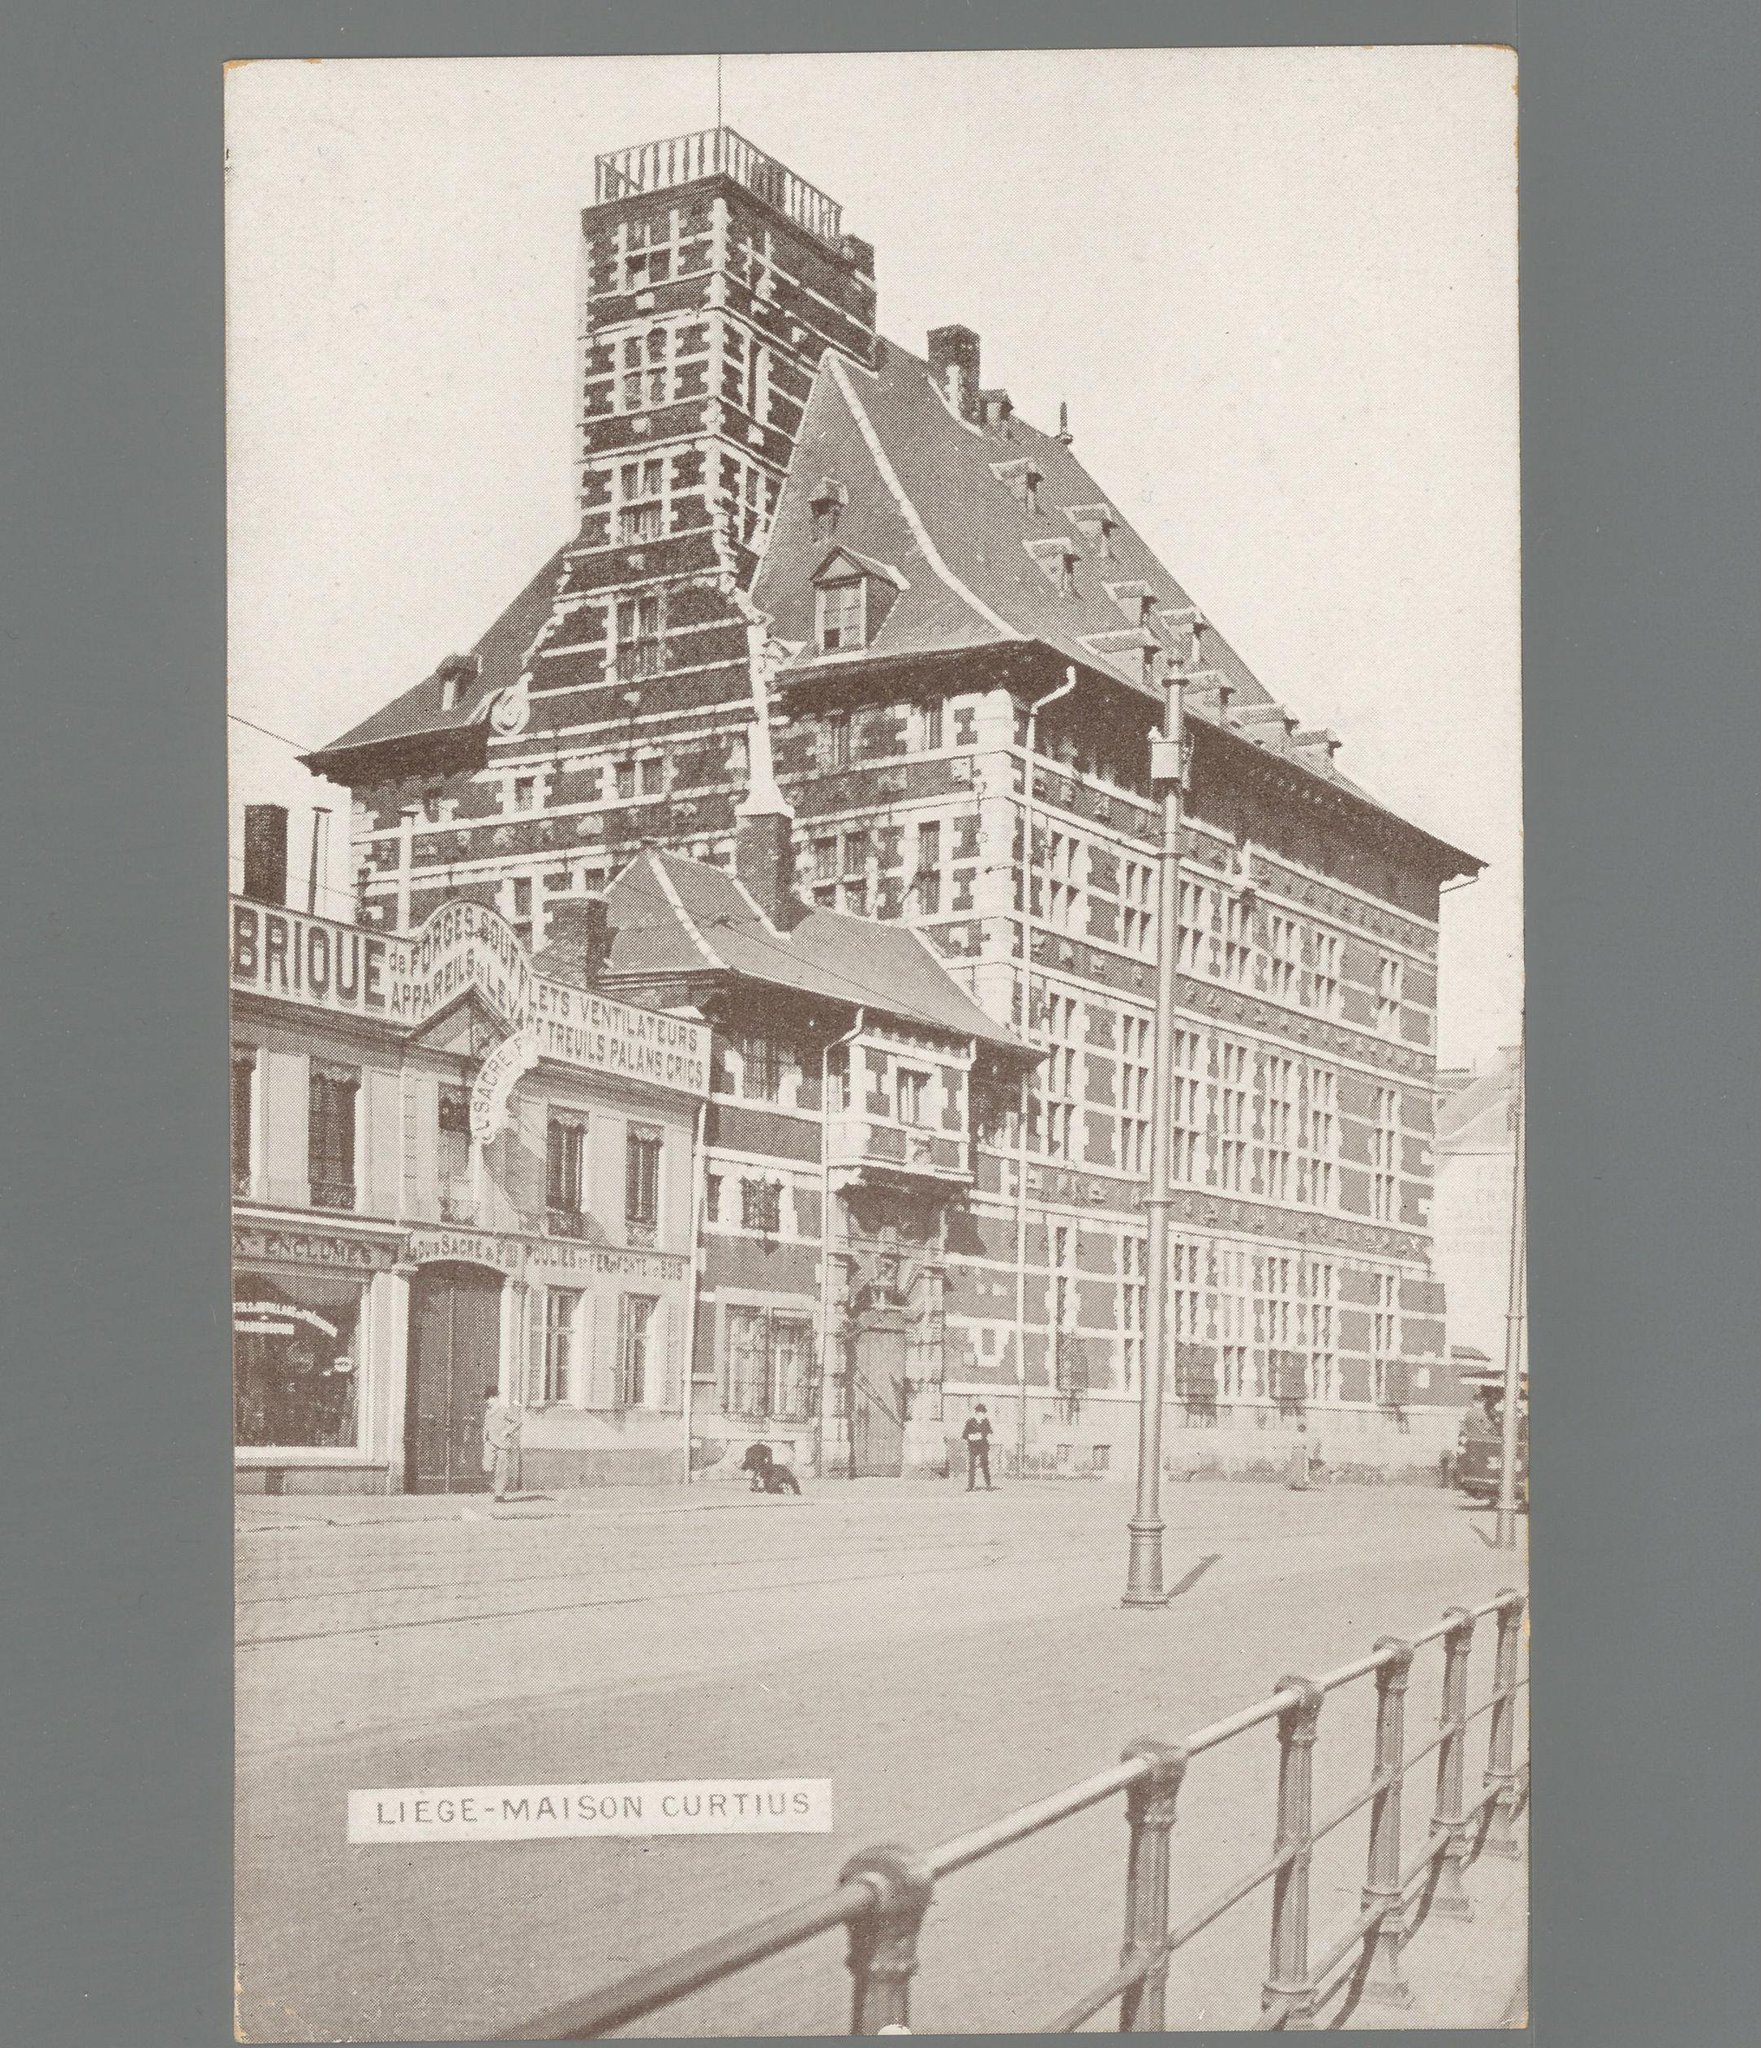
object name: ansichtkaart, prentbriefkaart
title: Liège. Maison Curtius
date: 1909-1913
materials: cardboard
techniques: autotype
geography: liège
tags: permanent exhibition, museum, city-view, and landscape with man-made constructions (+ city(-scape) with figures, staffage), liège